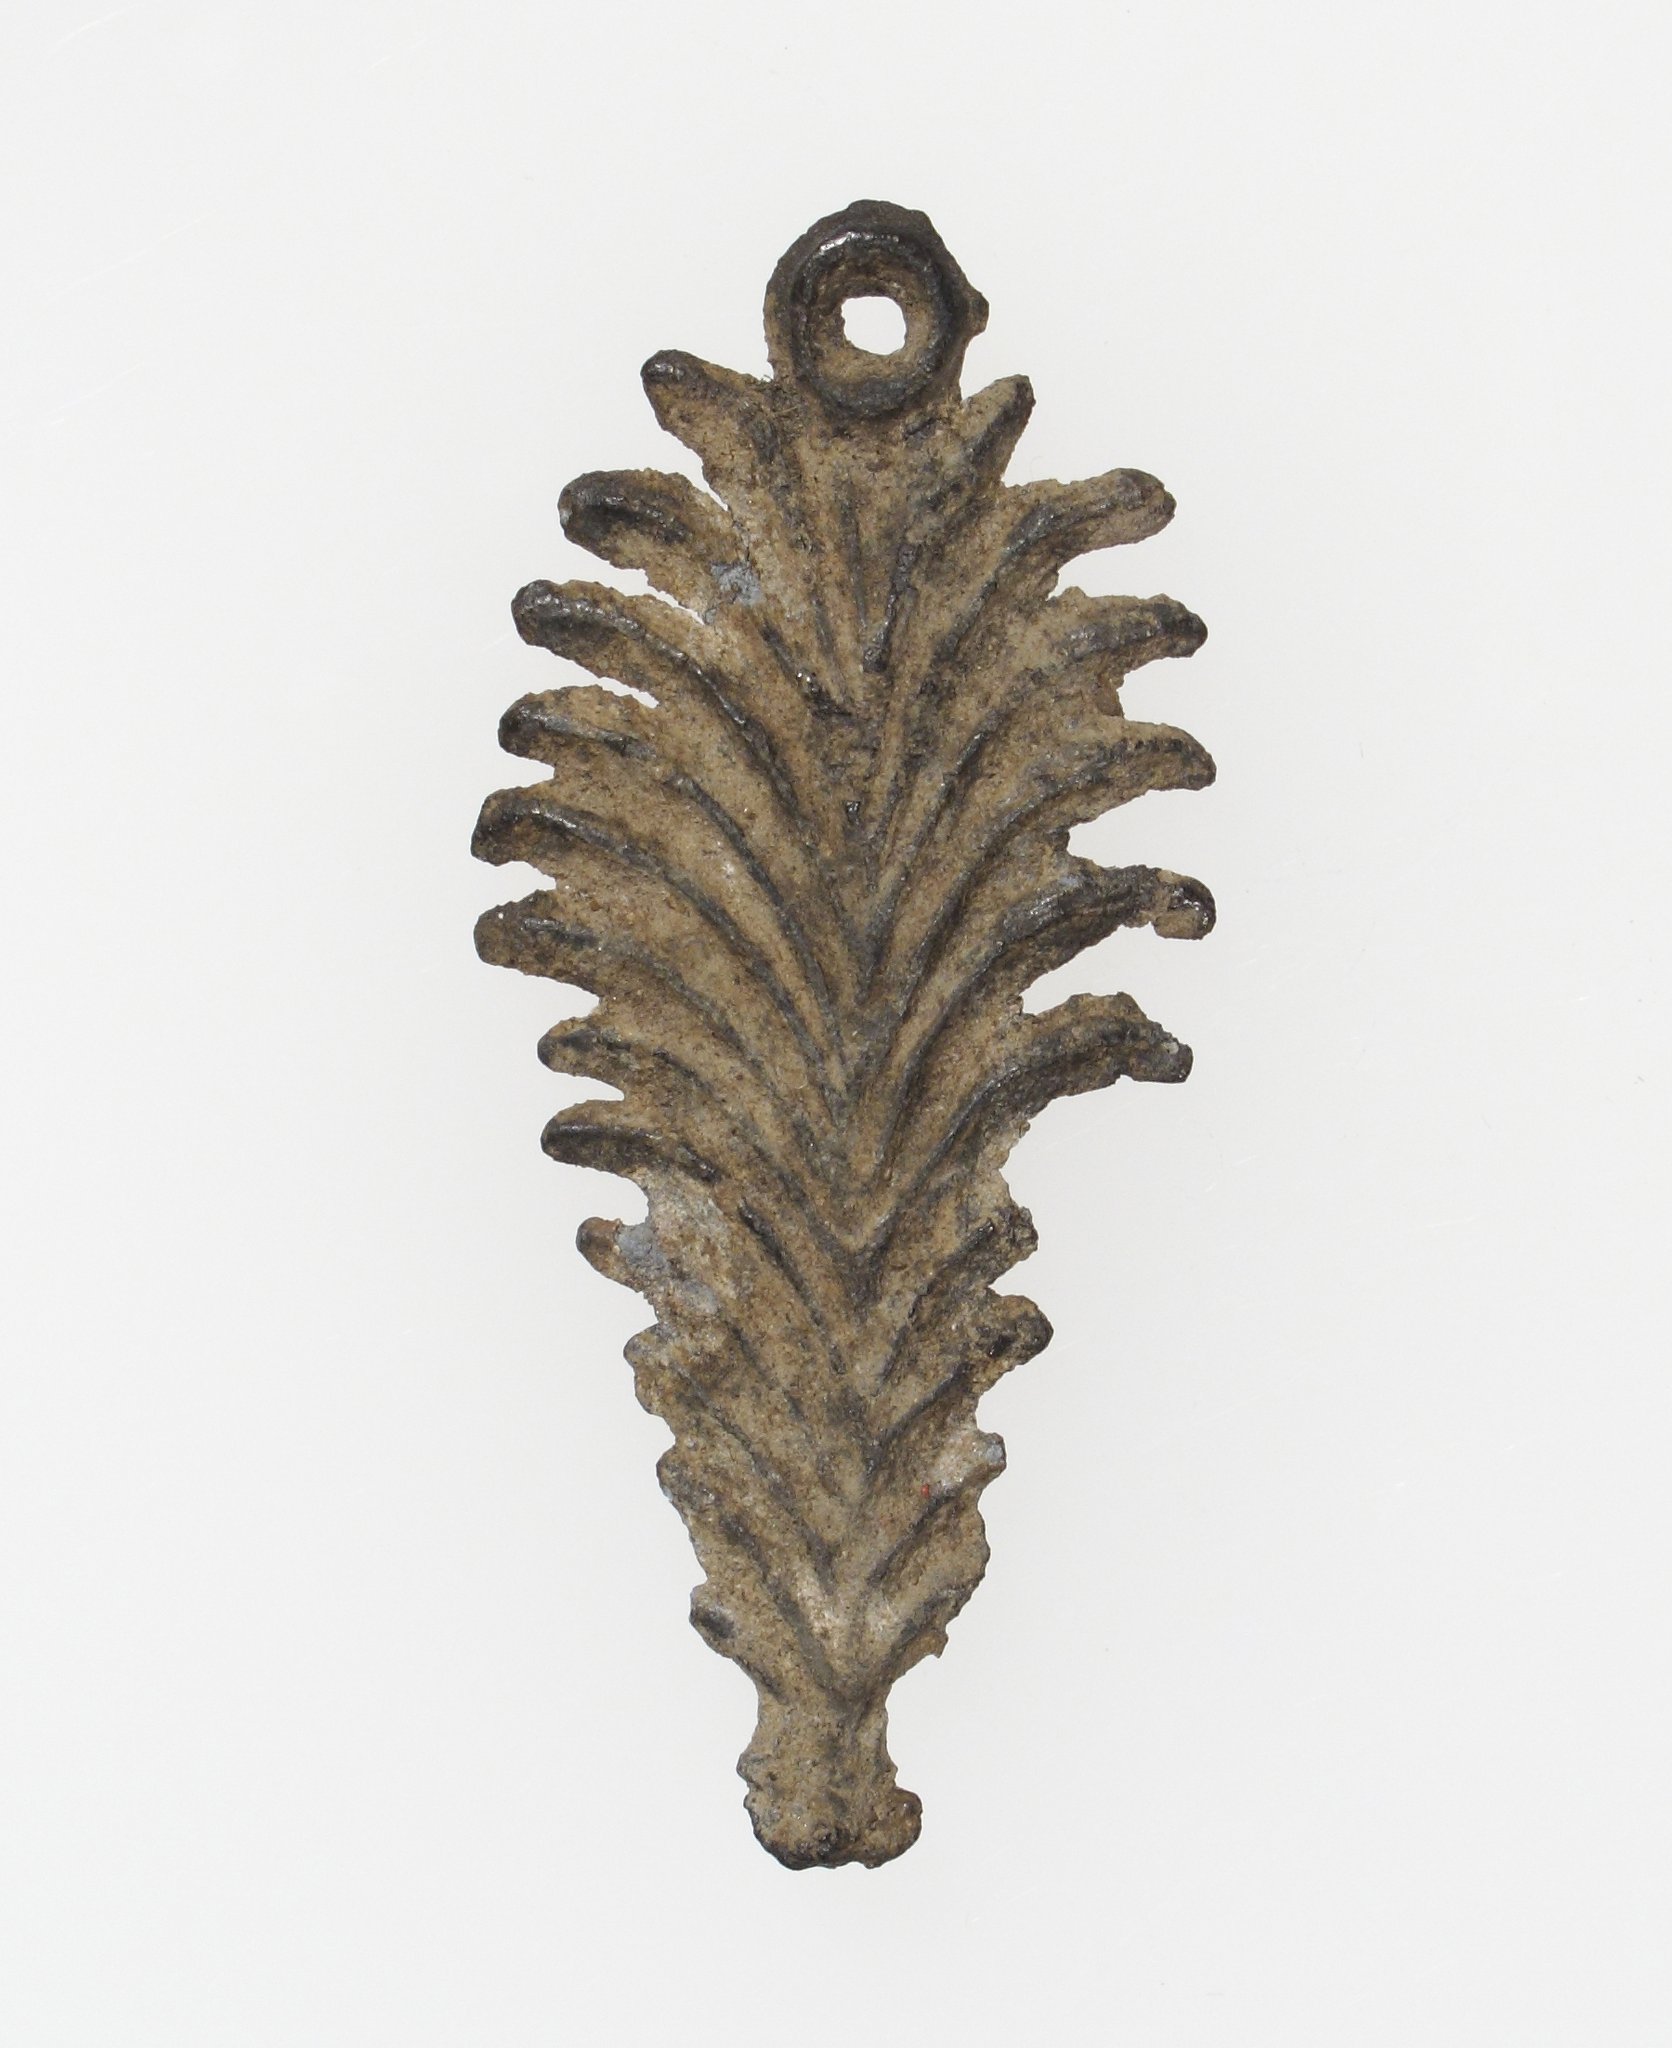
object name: pilgrim's badge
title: Pilgrim's Badge in the form of a Martyr's palm frond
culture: french or british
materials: lead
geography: france or england